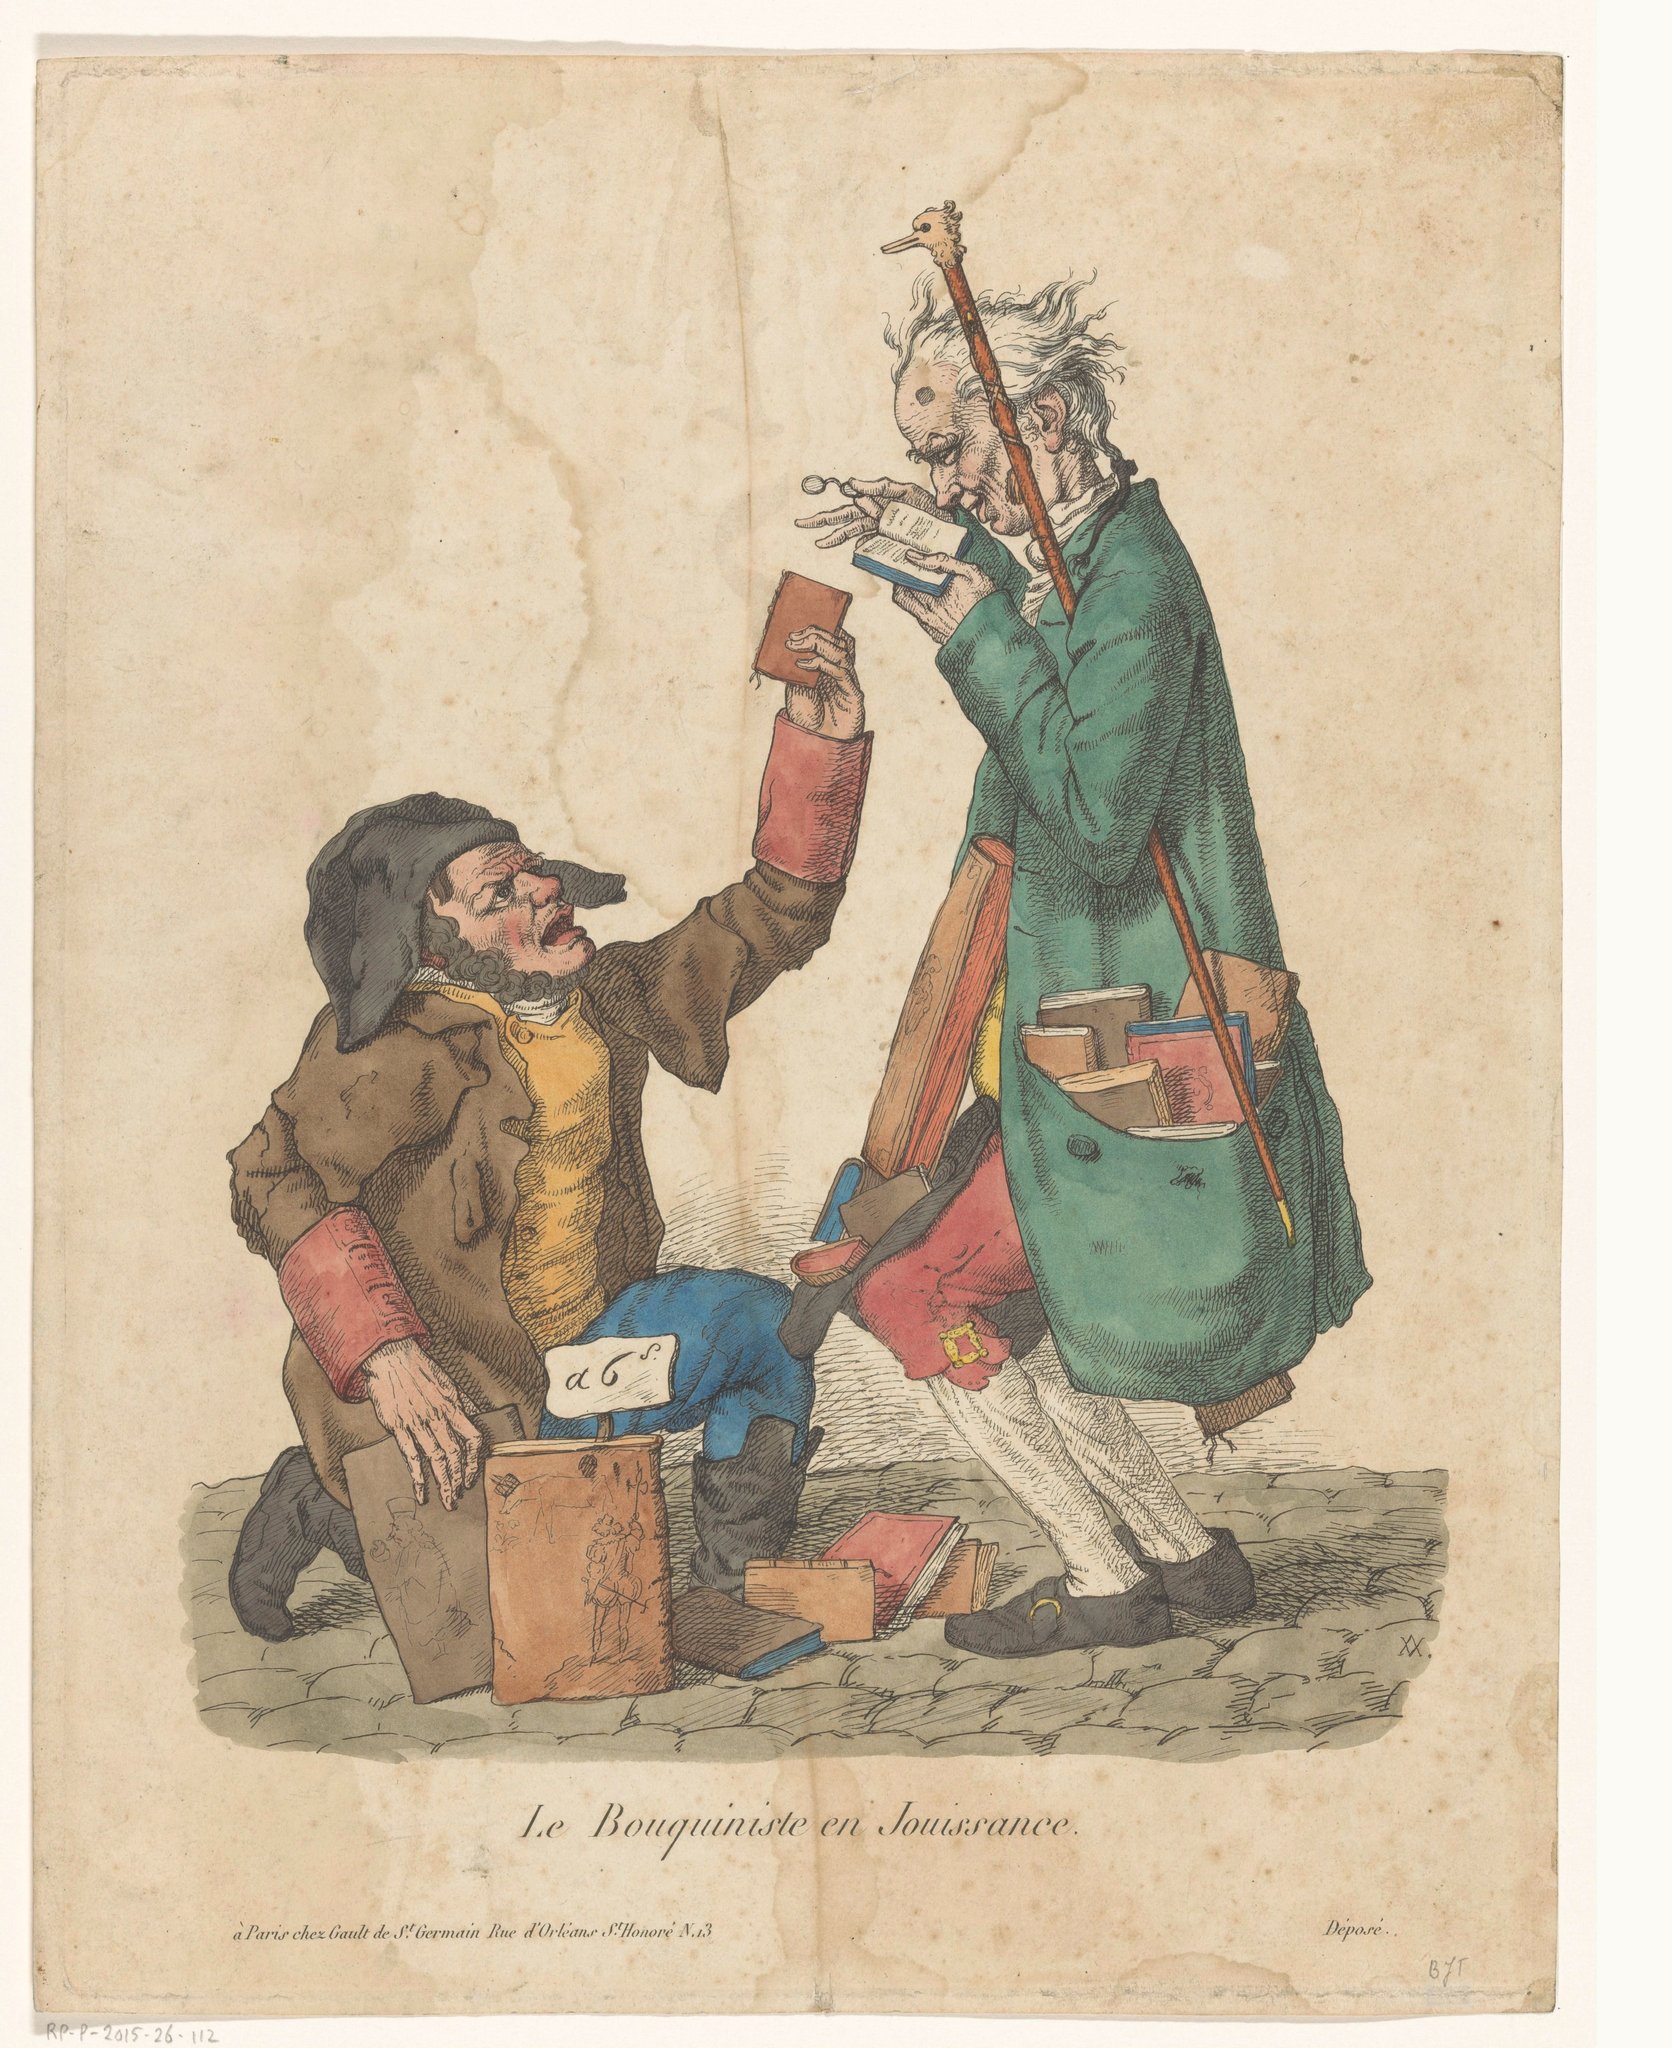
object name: print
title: Boekverkoper met een klant op straat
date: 1817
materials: paper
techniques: etching, hand coloring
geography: paris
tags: reading, street-trader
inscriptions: collector's mark: Lugt 4780, collector's mark: Lugt 4779, collector's mark: Lugt 2228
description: Een boekhandelaar, geknield tussen zijn boeken, biedt een klant een werk aan. De zakken van de klant puilen uit van de boeken.